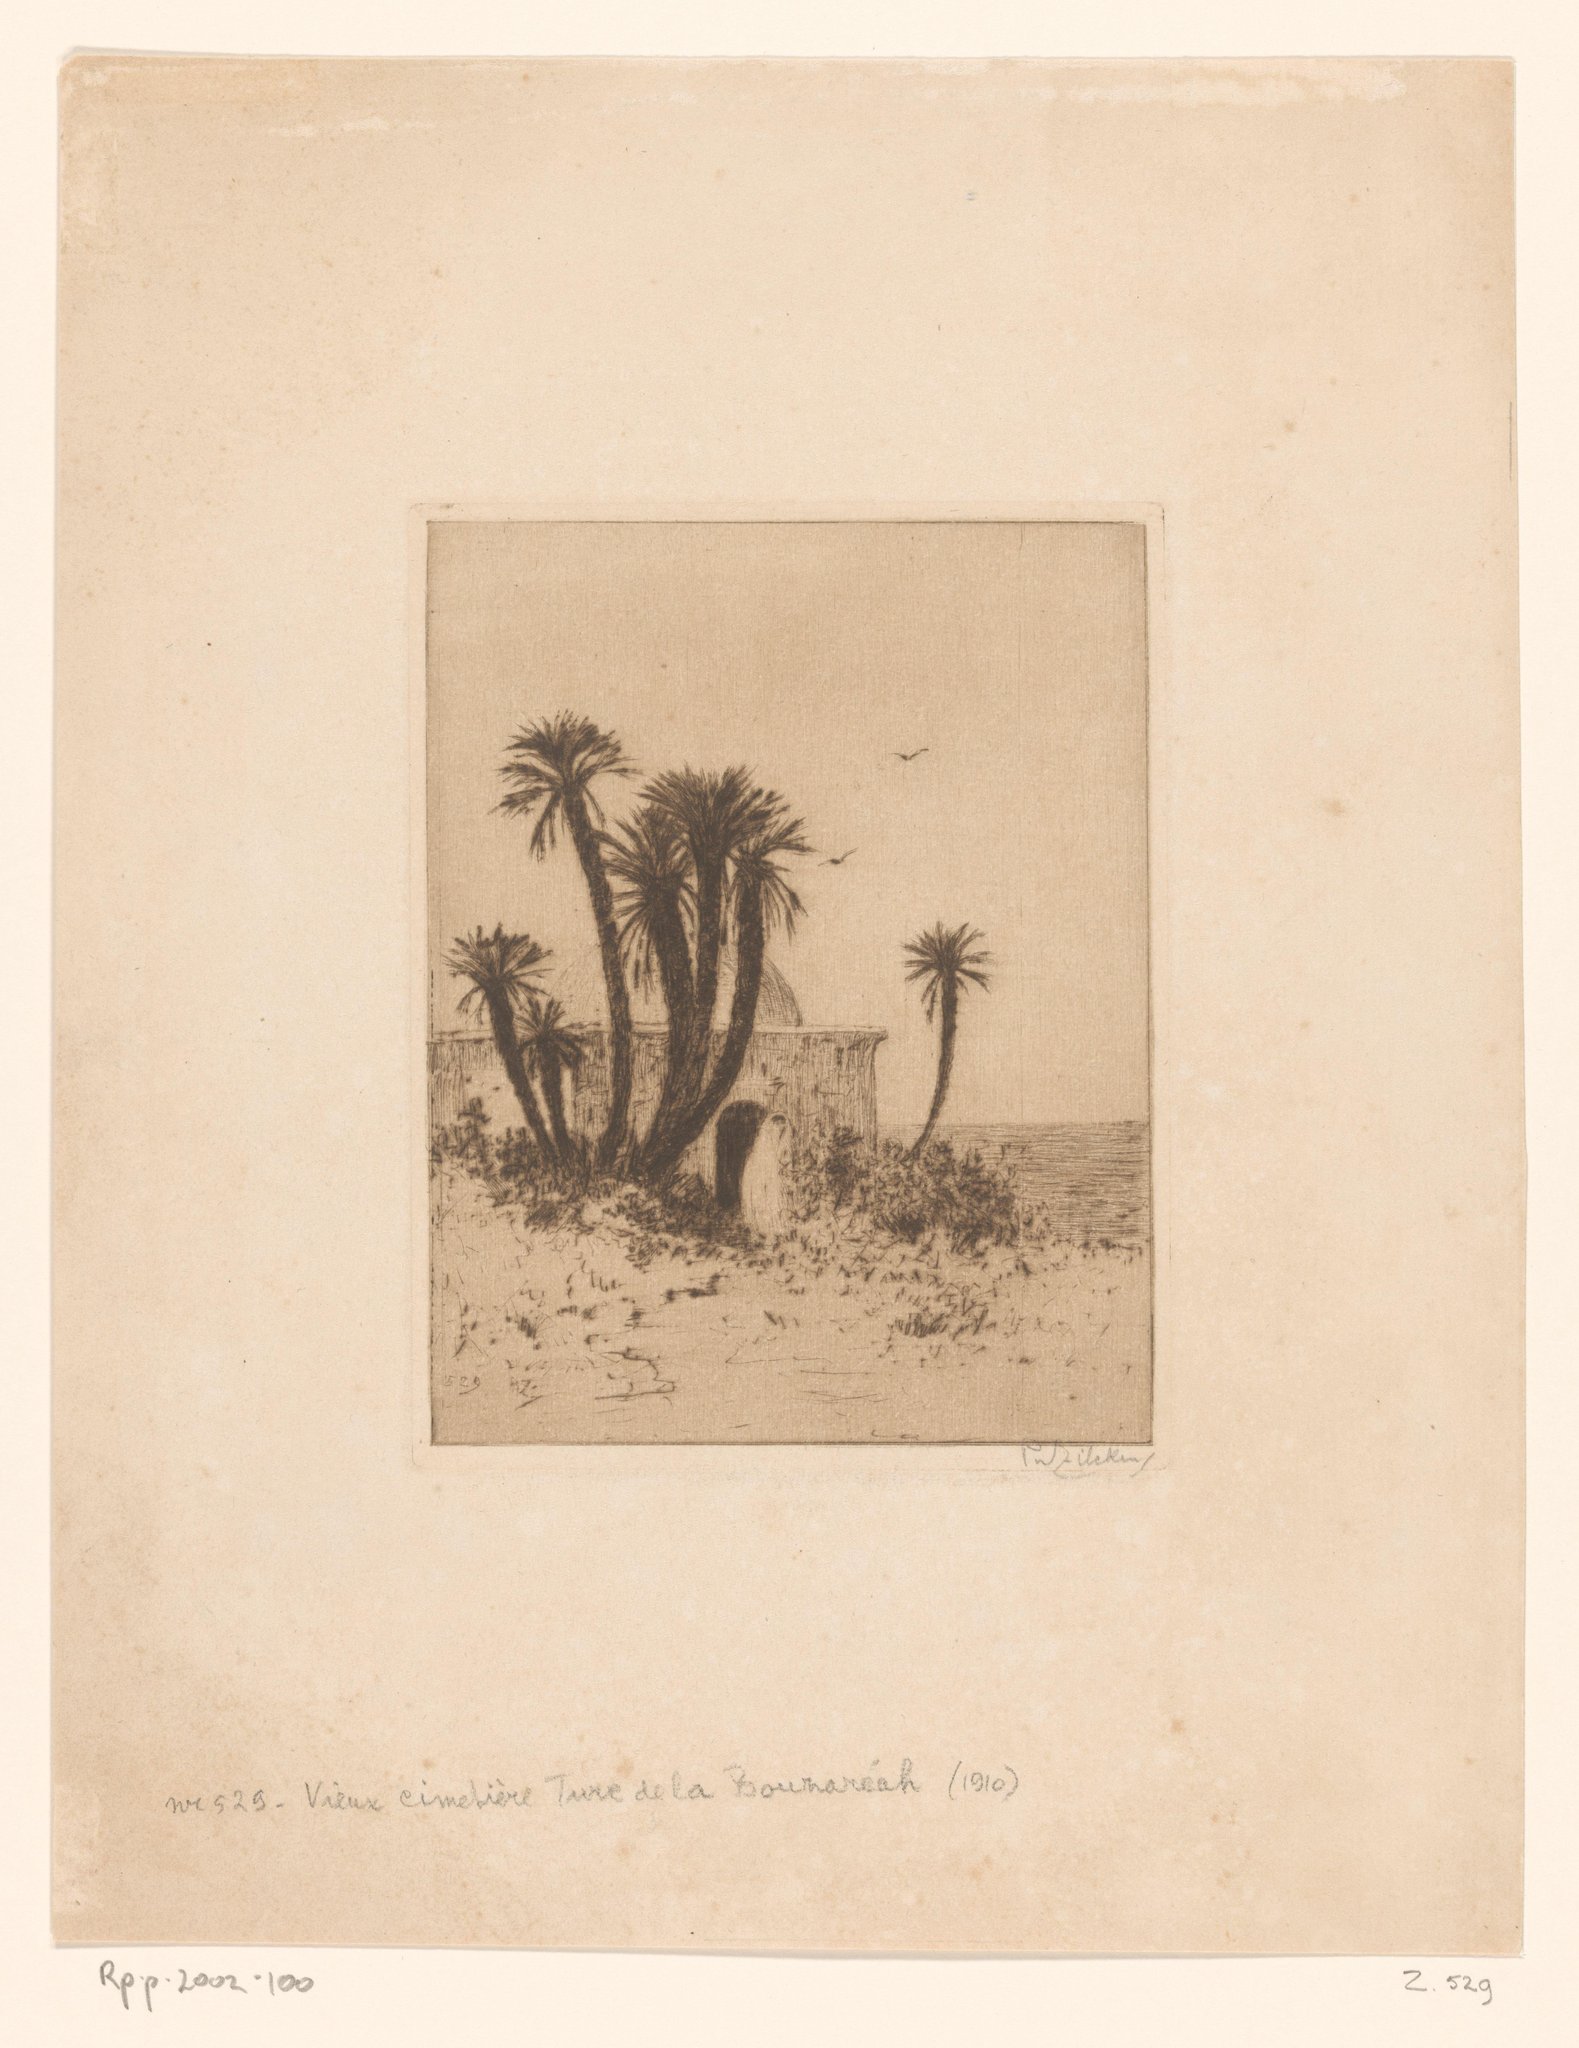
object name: print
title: Het oude kerkhof van Bouzaréah, bij Algiers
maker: philip zilcken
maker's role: draughtsman, painter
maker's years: 1857-1930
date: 1910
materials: paper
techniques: drypoint, intaglio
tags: trees: palm-tree, churchyard, cemetery, sea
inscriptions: collector's mark: Lugt 2228, collector's mark: Lugt 2760